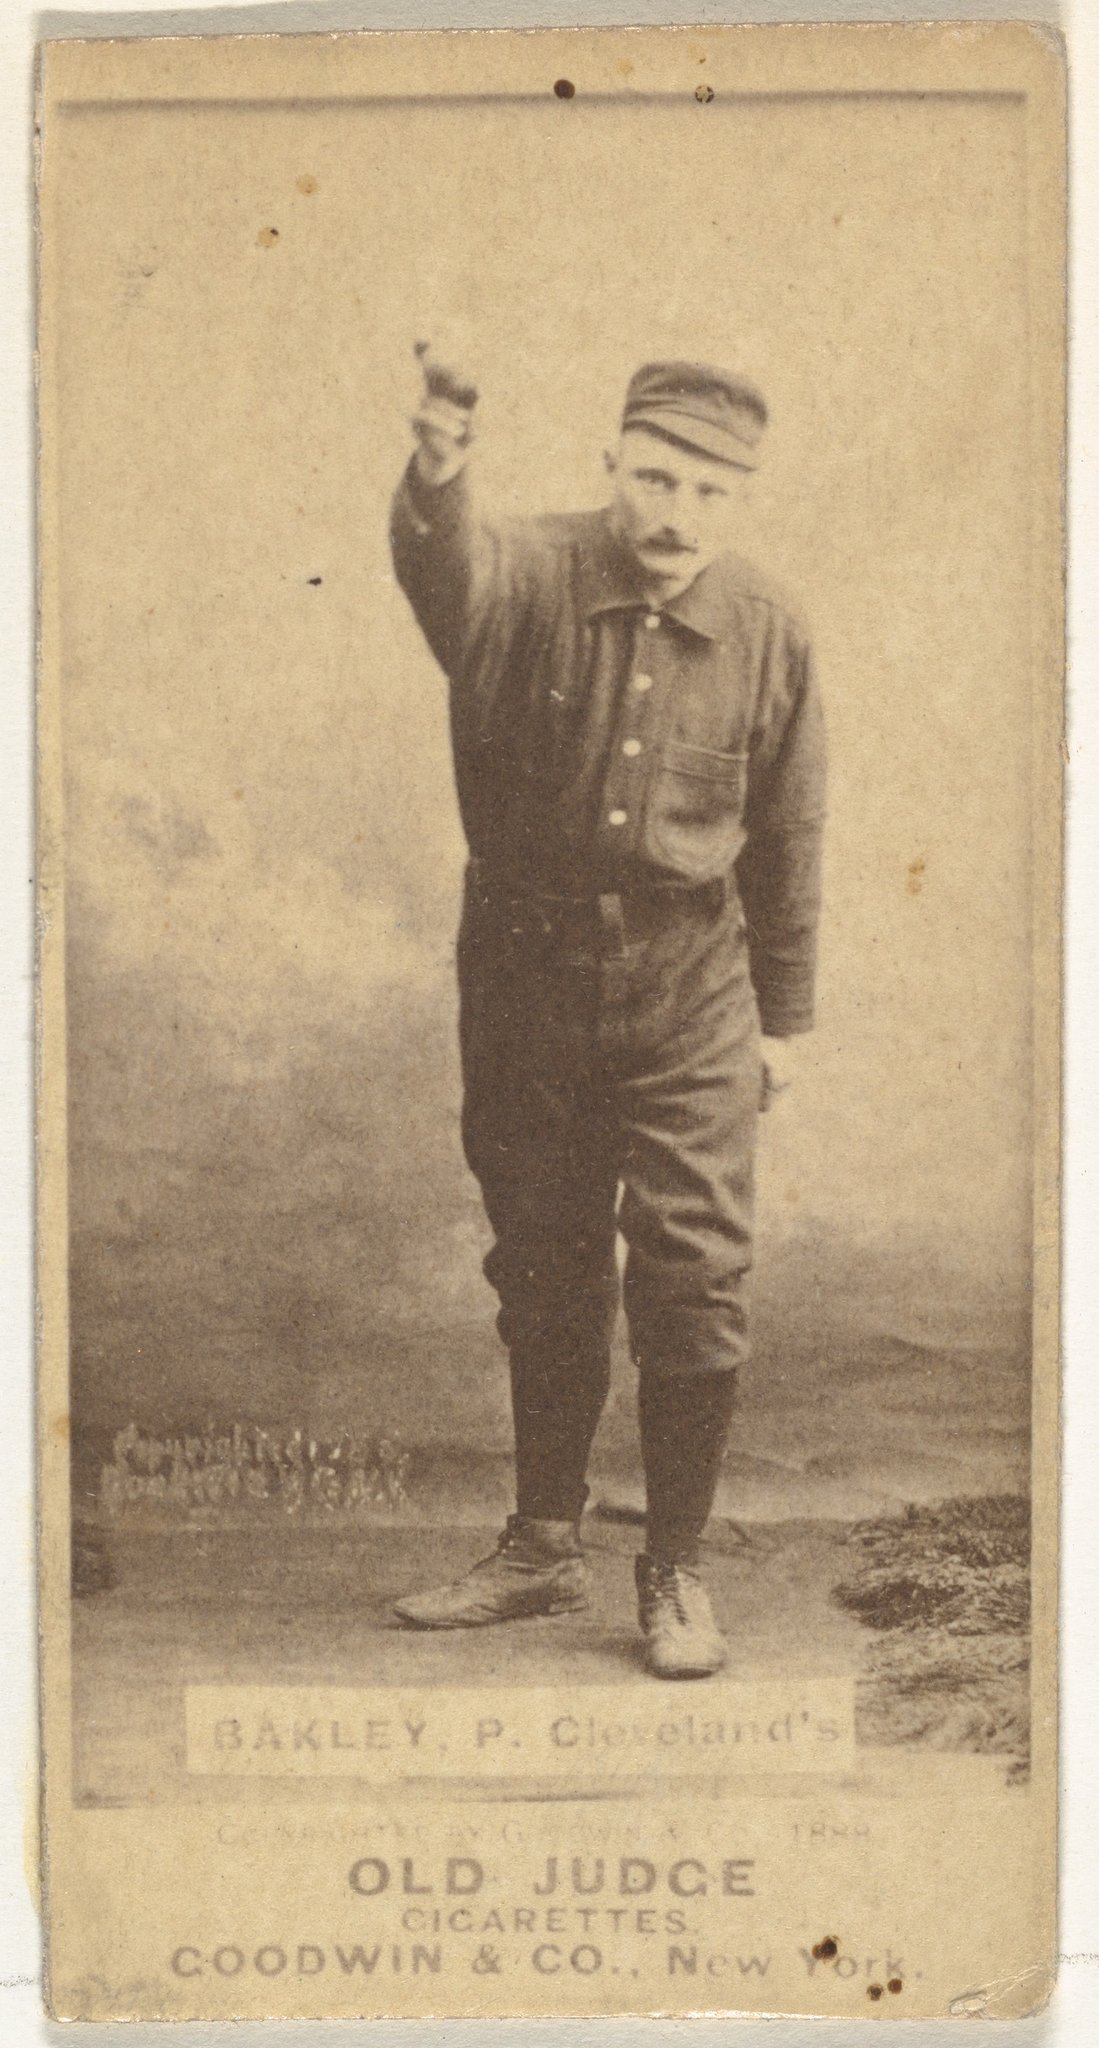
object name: baseball card, photograph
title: Edward Enoch "Jersey" Bakely, Pitcher, Cleveland, from the Old Judge series (N172) for Old Judge Cigarettes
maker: goodwin & company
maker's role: publisher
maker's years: 1850-1950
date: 1888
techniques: albumen silver print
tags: men,portraits,baseball,athletes